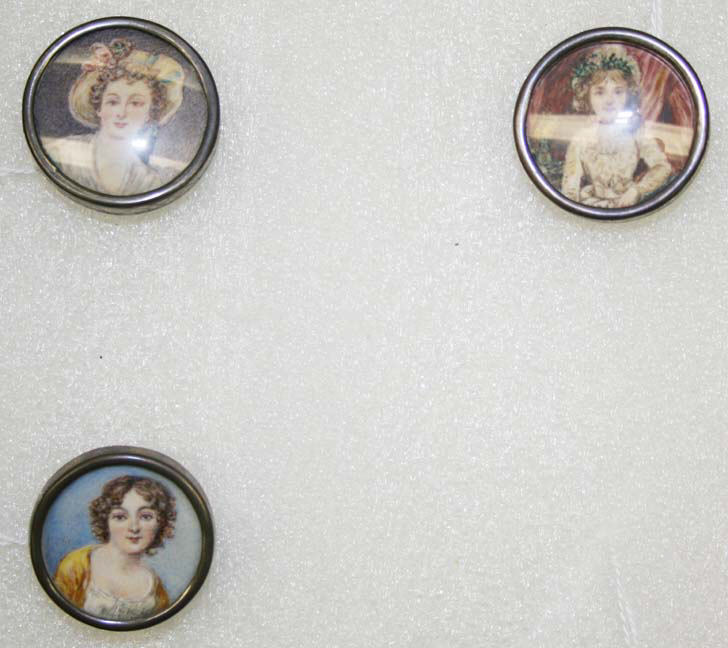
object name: button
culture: italian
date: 1780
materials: ivory, metal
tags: portraits,women